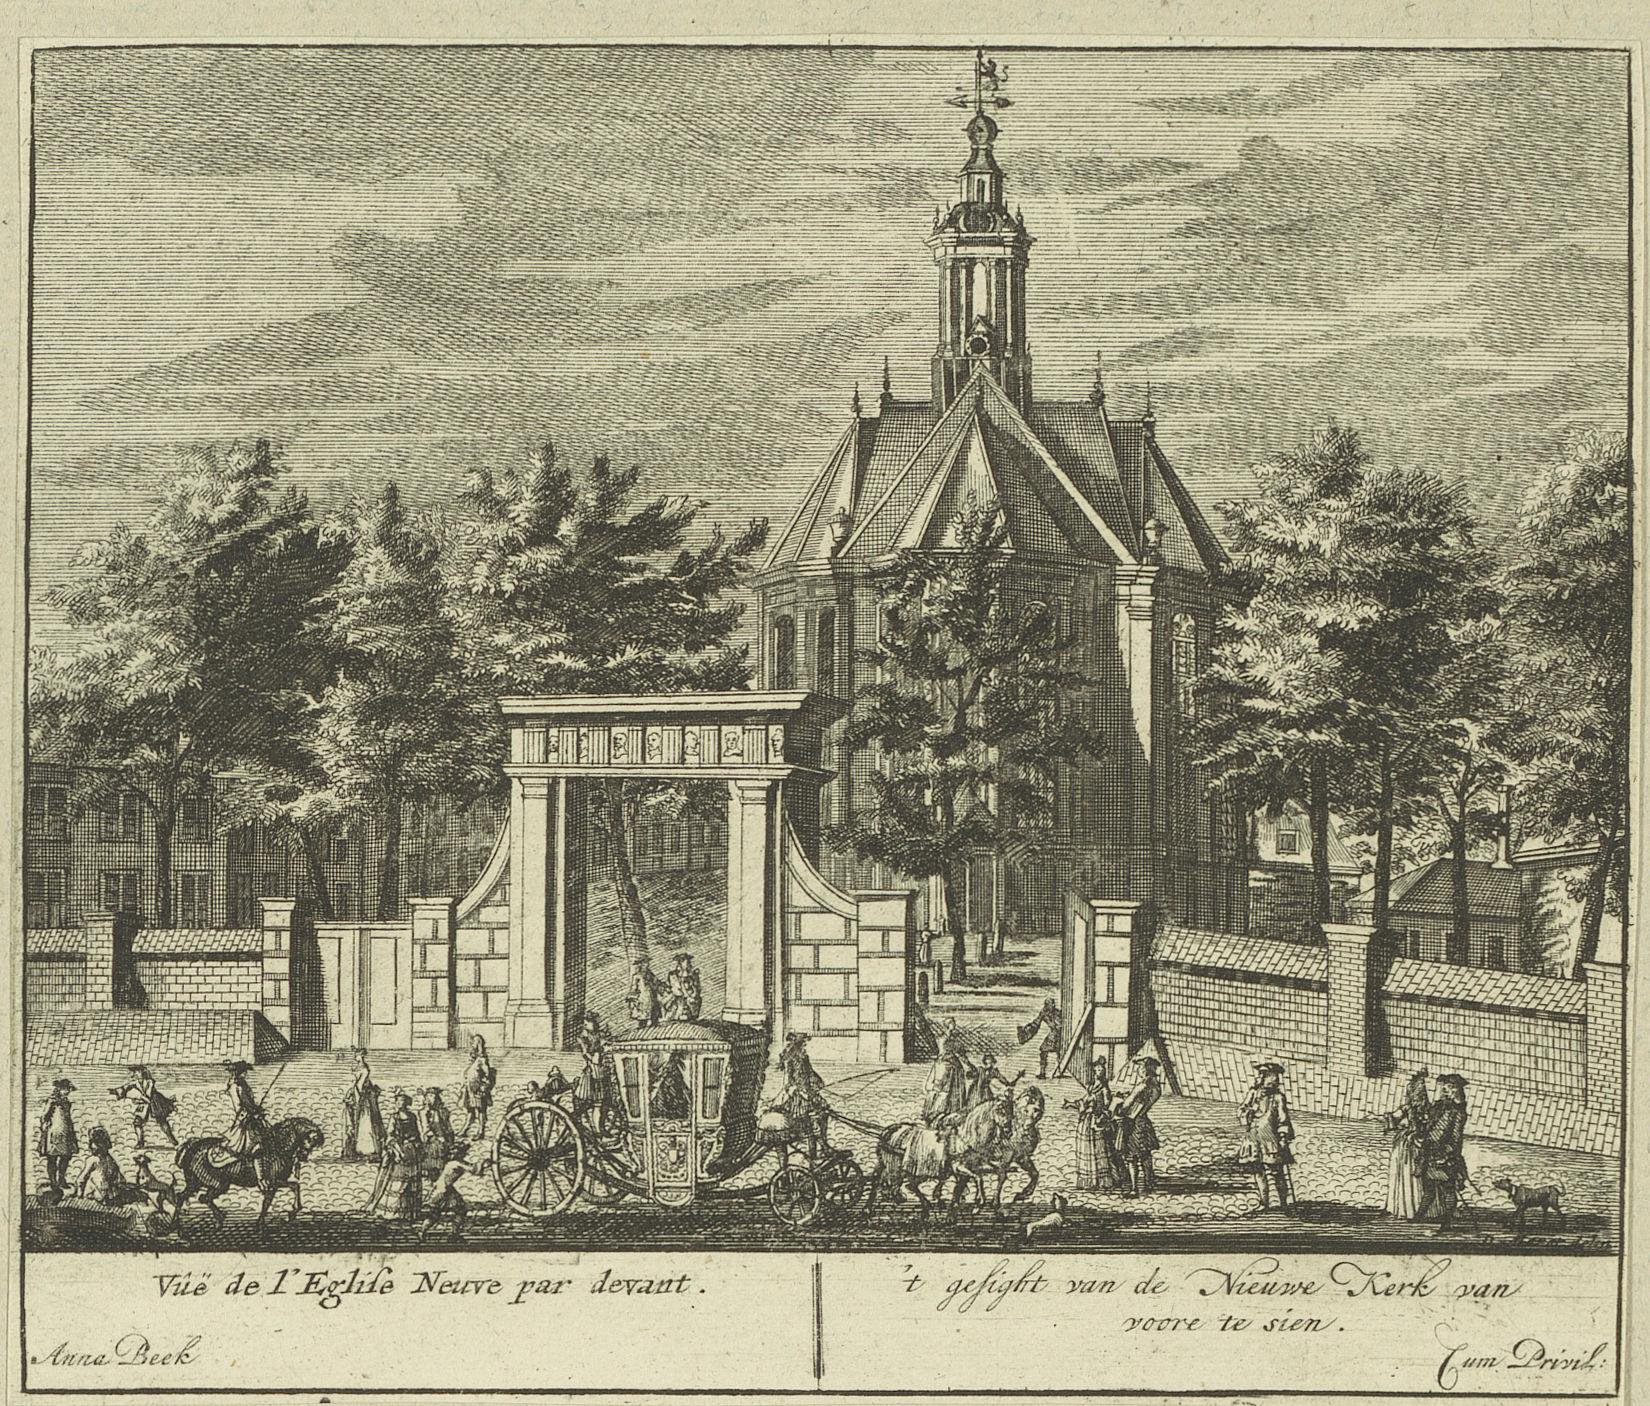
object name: print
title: Gezicht op de Nieuwe Kerk te Den Haag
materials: paper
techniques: engraving, etching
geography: the hague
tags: church (exterior), gate, entrance, street (+ city(-scape) with figures, staffage)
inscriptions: collector's mark: Lugt 2228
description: Mogelijk uitgegeven als onderdeel van een serie van veertien gezichten in Den Haag. Zie ook RP-P-AO-12-34A, RP-P-AO-12-118-1, RP-P-AO-12-118-2, RP-P-AO-12-118-3, RP-P-AO-12-118-4, RP-P-AO-12-118-5, RP-P-AO-12-118-6, RP-P-AO-12-118-7, RP-P-AO-12-118-8, RP-P-AO-12-118-9, RP-P-AO-12-118-11, RP-P-AO-12-118-12, RP-P-AO-12-118-13, RP-P-2016-2145, RP-P-2016-2146, RP-P-2016-2147, RP-P-2016-2148, RP-P-2016-2149, RP-P-2016-2150 en RP-P-2016-2151.